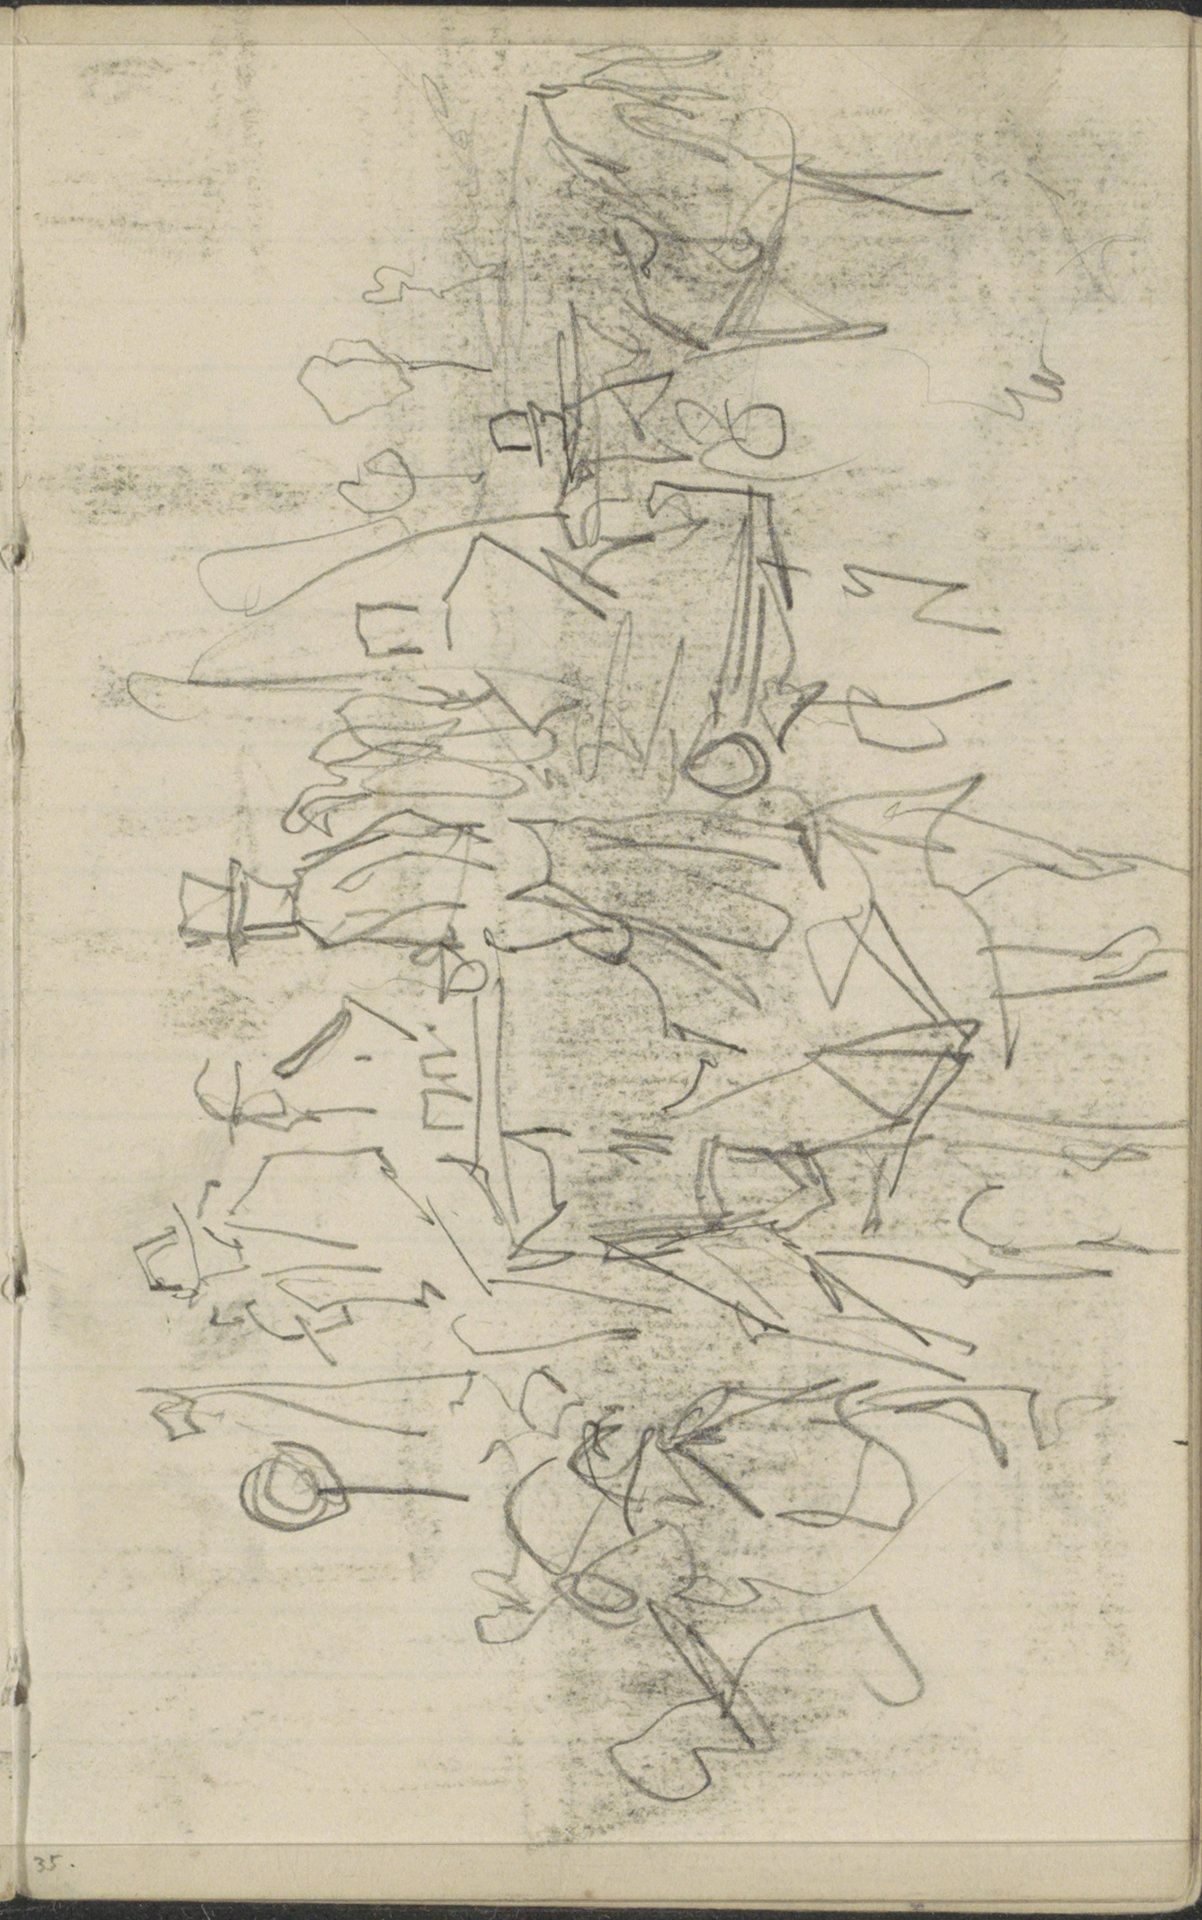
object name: sketchbook leaf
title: Paarden en figuren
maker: marius bauer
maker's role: draughtsman, print maker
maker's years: 1867-1932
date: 1881-1885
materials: pencil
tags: anatomy (non-medical), horse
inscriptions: annotation: ‘Delft’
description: Mogelijk een optocht waarbij de paarden een koets trekken waarop de figuren zijn gezeten. Pagina 35 uit een schetsboek met 26 bladen.